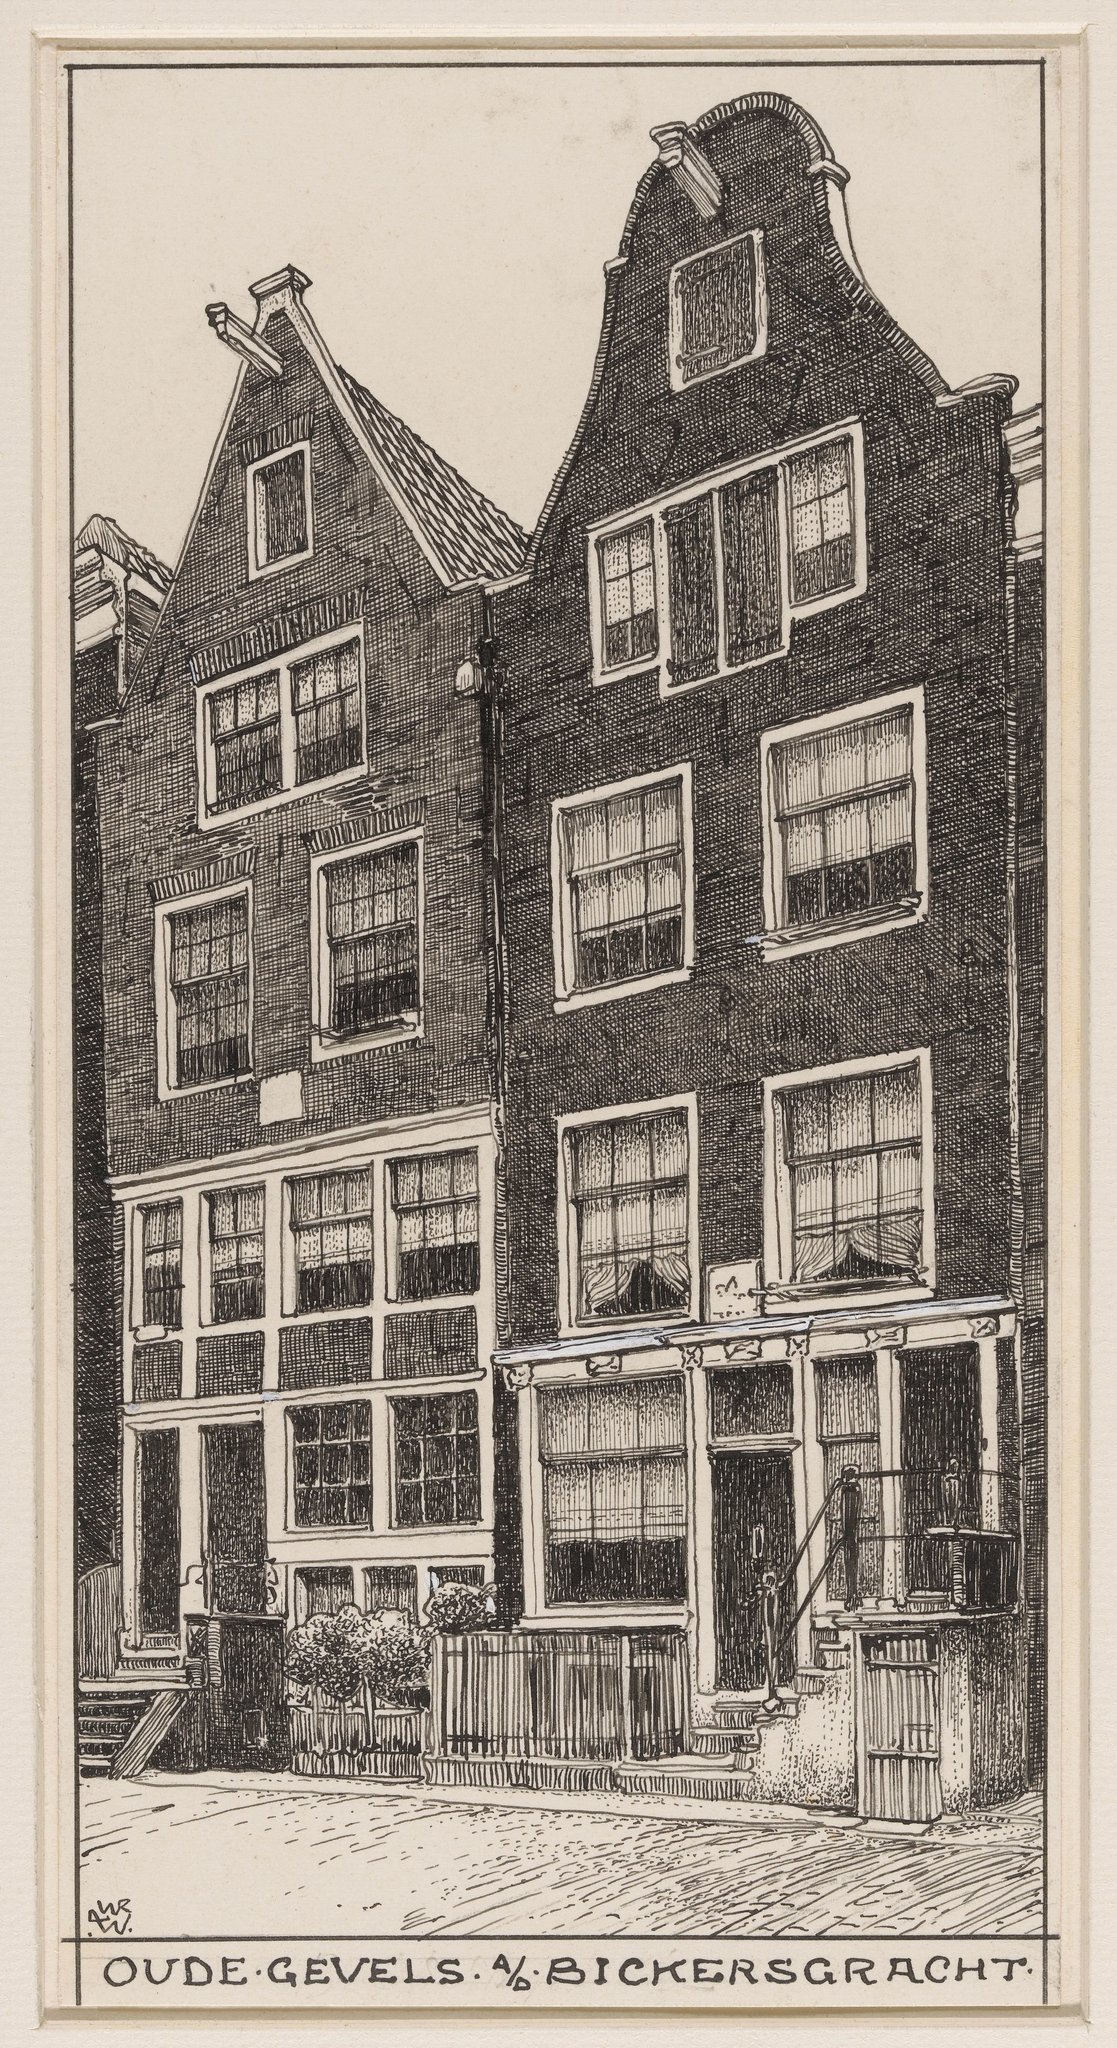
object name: drawing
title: Oude gevels aan de Bickersgracht te Amsterdam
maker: willem wenckebach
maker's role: designer, draughtsman, painter, print maker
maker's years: 1860-1937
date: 1870-1926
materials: paint, ink, paper, pencil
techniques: pen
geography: amsterdam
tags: street, amsterdam